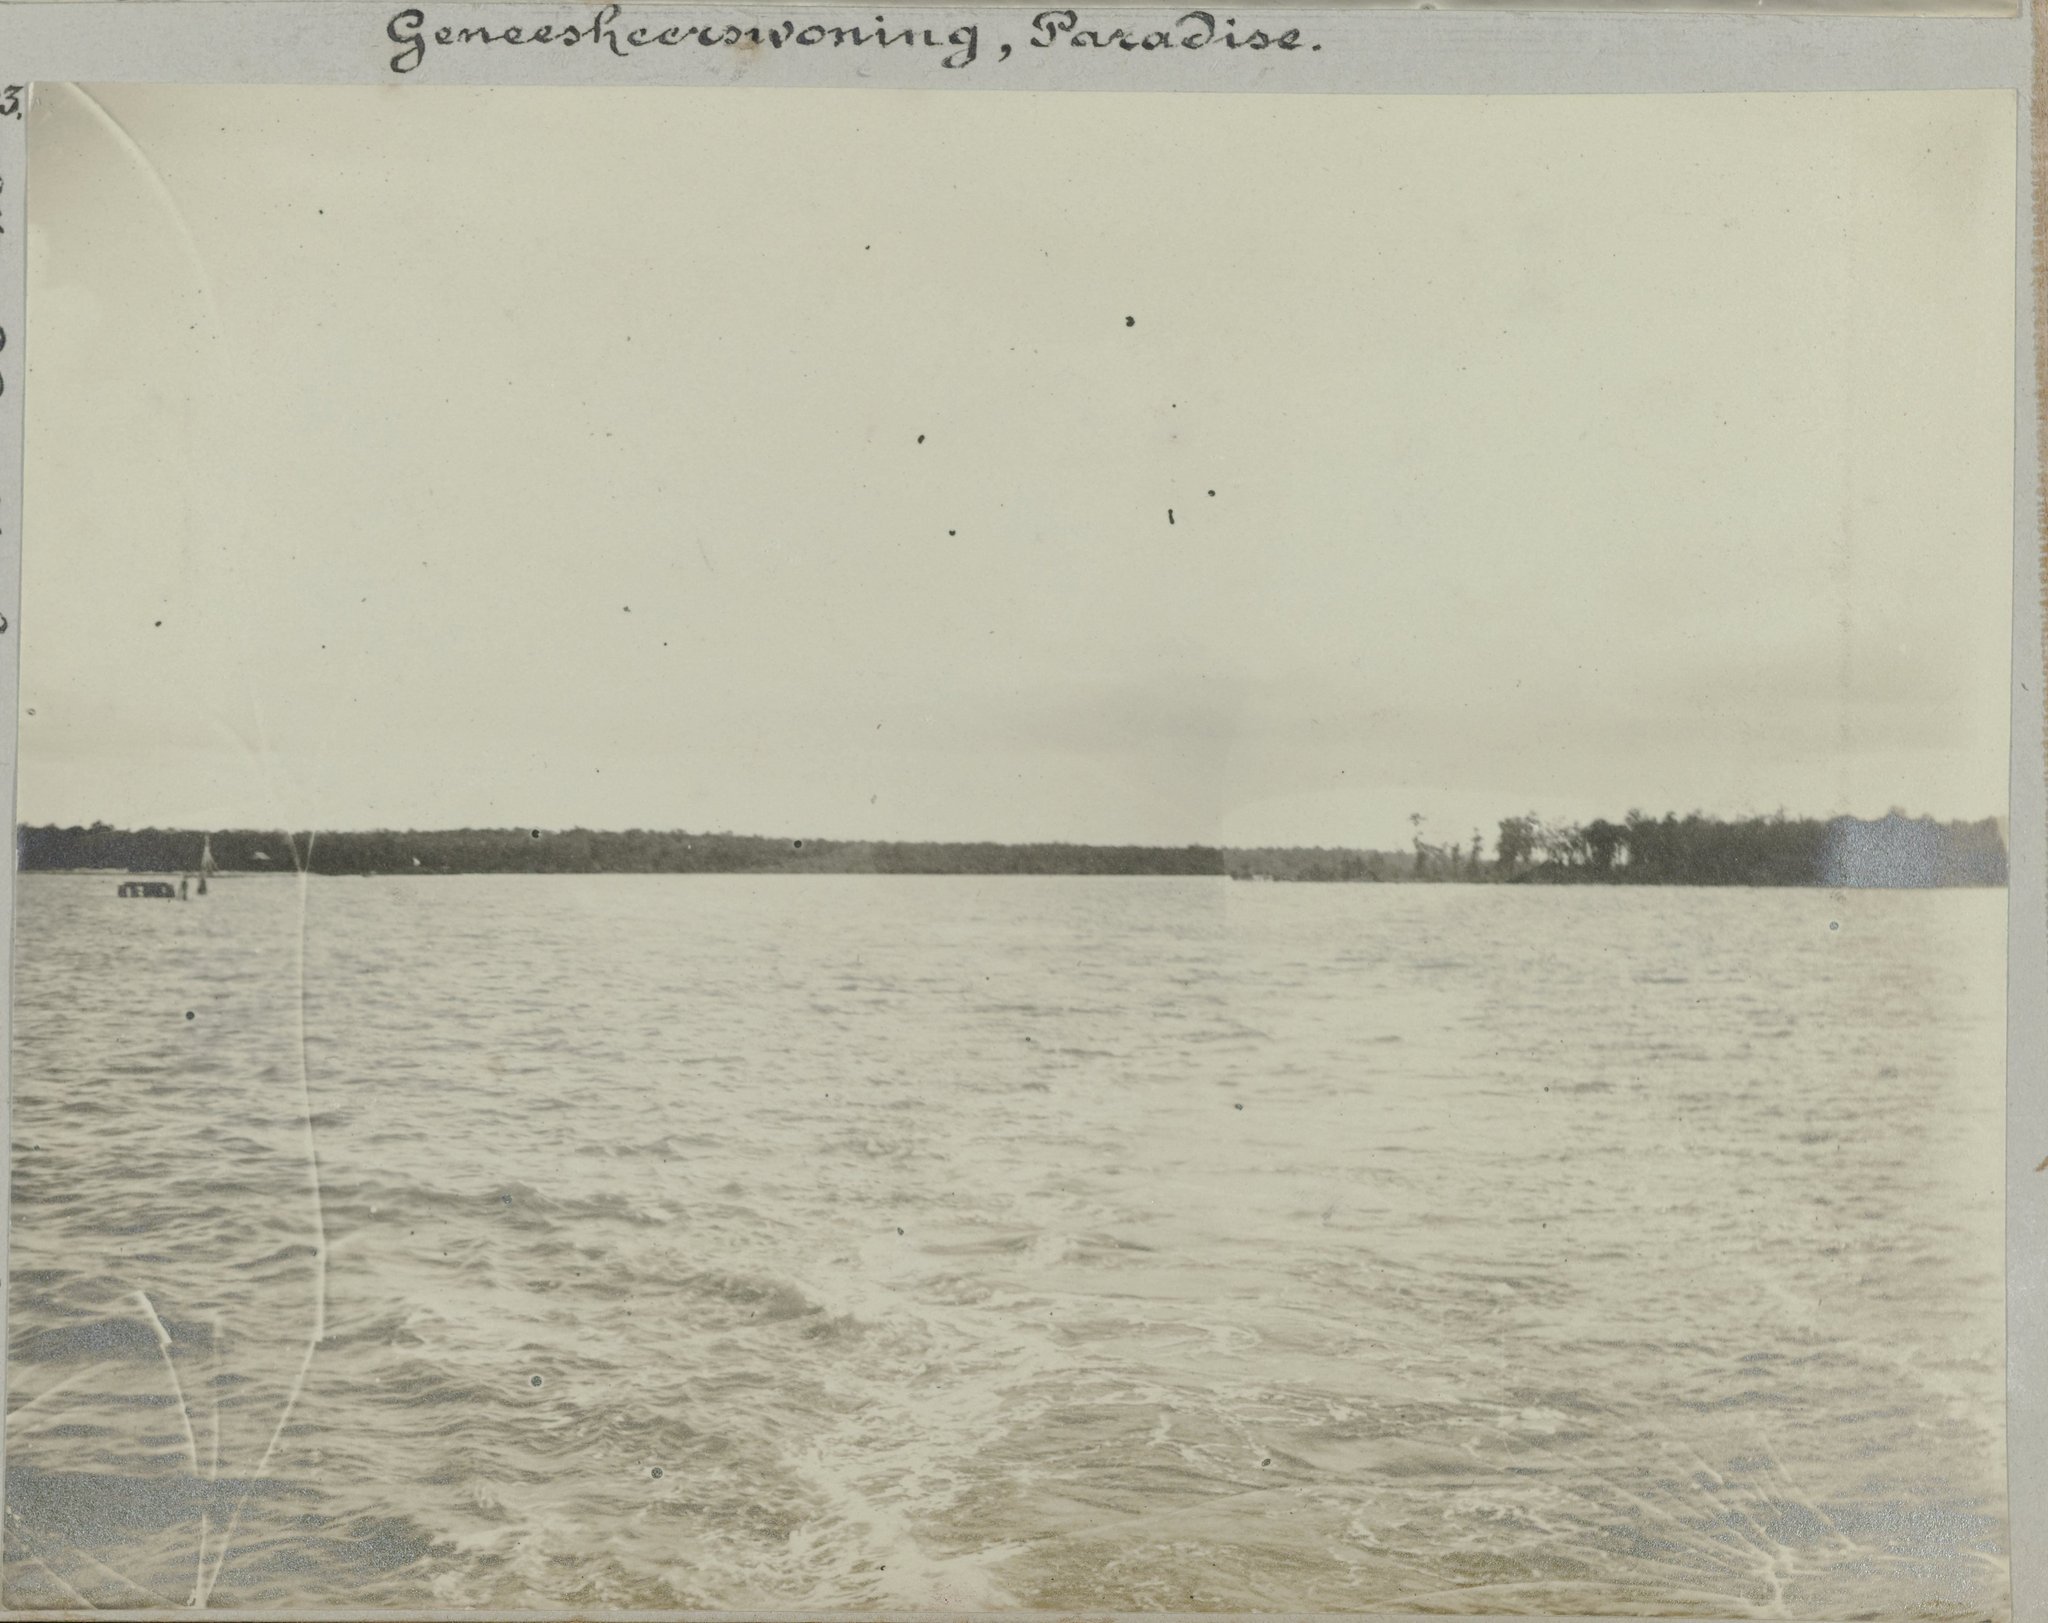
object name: photograph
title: Mond der Nickerierivier, met overblijfsel van den steiger van het verzwolgen Nickerie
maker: gomez burke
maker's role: fotograaf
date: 1891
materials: photographic support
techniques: gelatin silver print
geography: suriname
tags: suriname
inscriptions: inscription: ‘G.B.23. / Mond der Nickerierivier, met overblijfsel van den steiger van het verzwolgen Nickerie.’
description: Gezicht over de Nickerie rivier met restanten van een steiger van het door de rivier verzwolgen plaatsje Nickerie (of Nieuw-Rotterdam). Onderdeel van het fotoalbum Souvenir de Voyage (deel 4), over het leven van de familie Dooyer in en rond de plantage Ma Retraite in Suriname in de jaren 1906-1913.